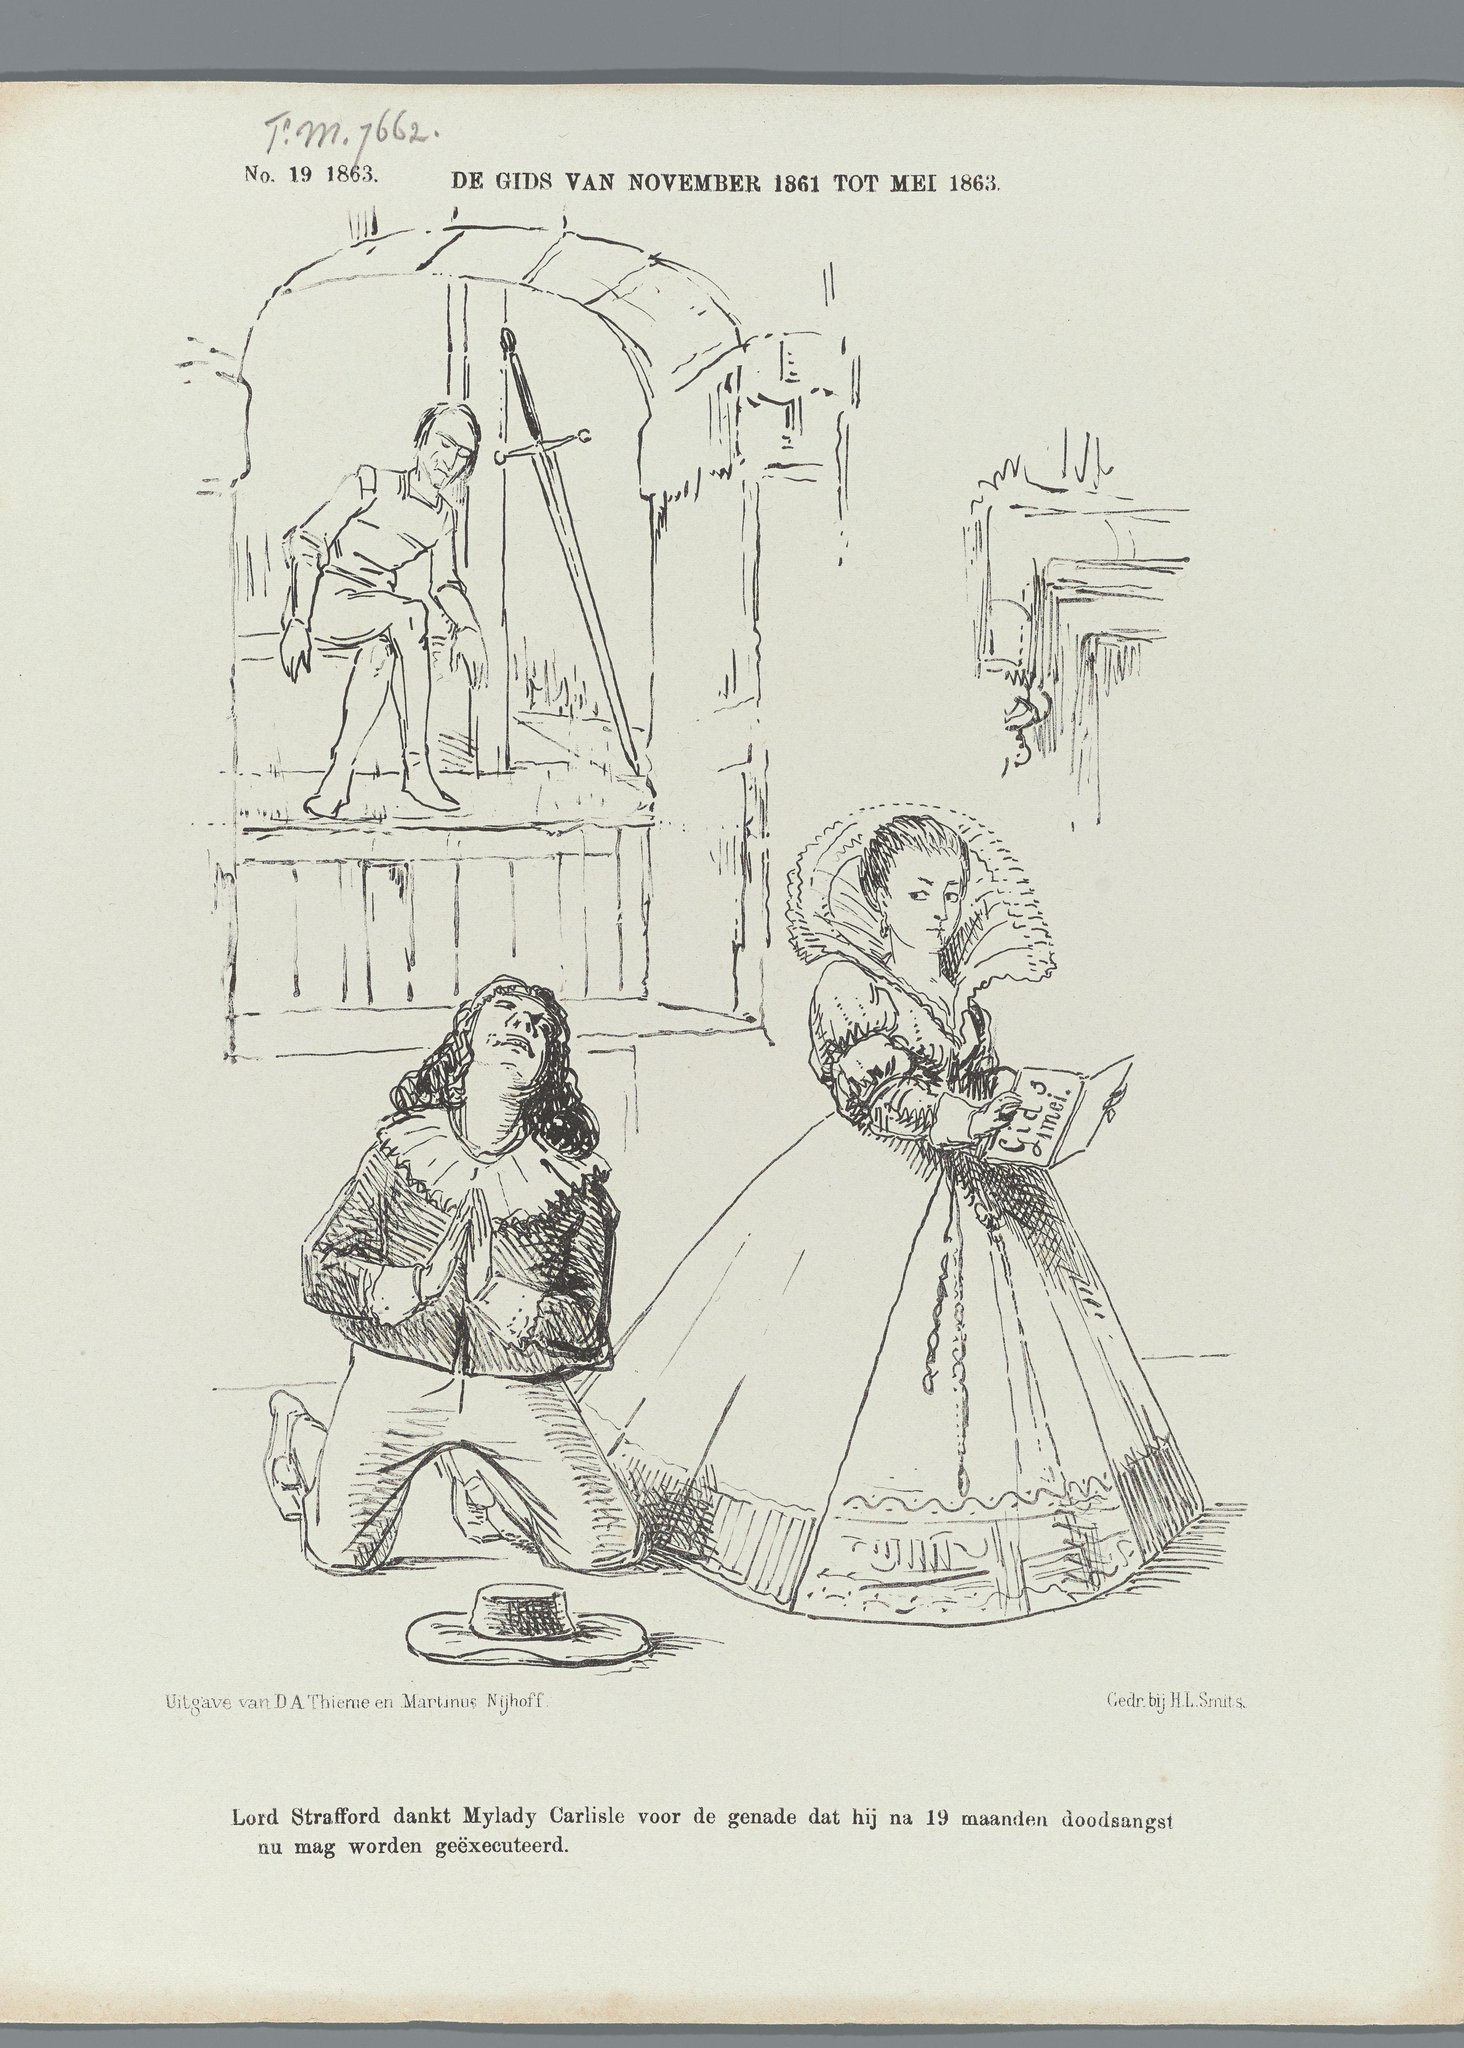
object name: print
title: De gids van november 1861 tot mei 1863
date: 1863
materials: paper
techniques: lithograph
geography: arnhem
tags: hendrik jan schimmel, literary characters and objects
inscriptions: collector's mark: Lugt 2228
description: Spotprent op publicatie van H.J. Schimmels roman 'Mylady Carlisle' gedurende 19 maanden in De Gids. Plaat verschenen bij het weekblad De Nederlandsche Spectator, nr. 19, 9 mei 1863.